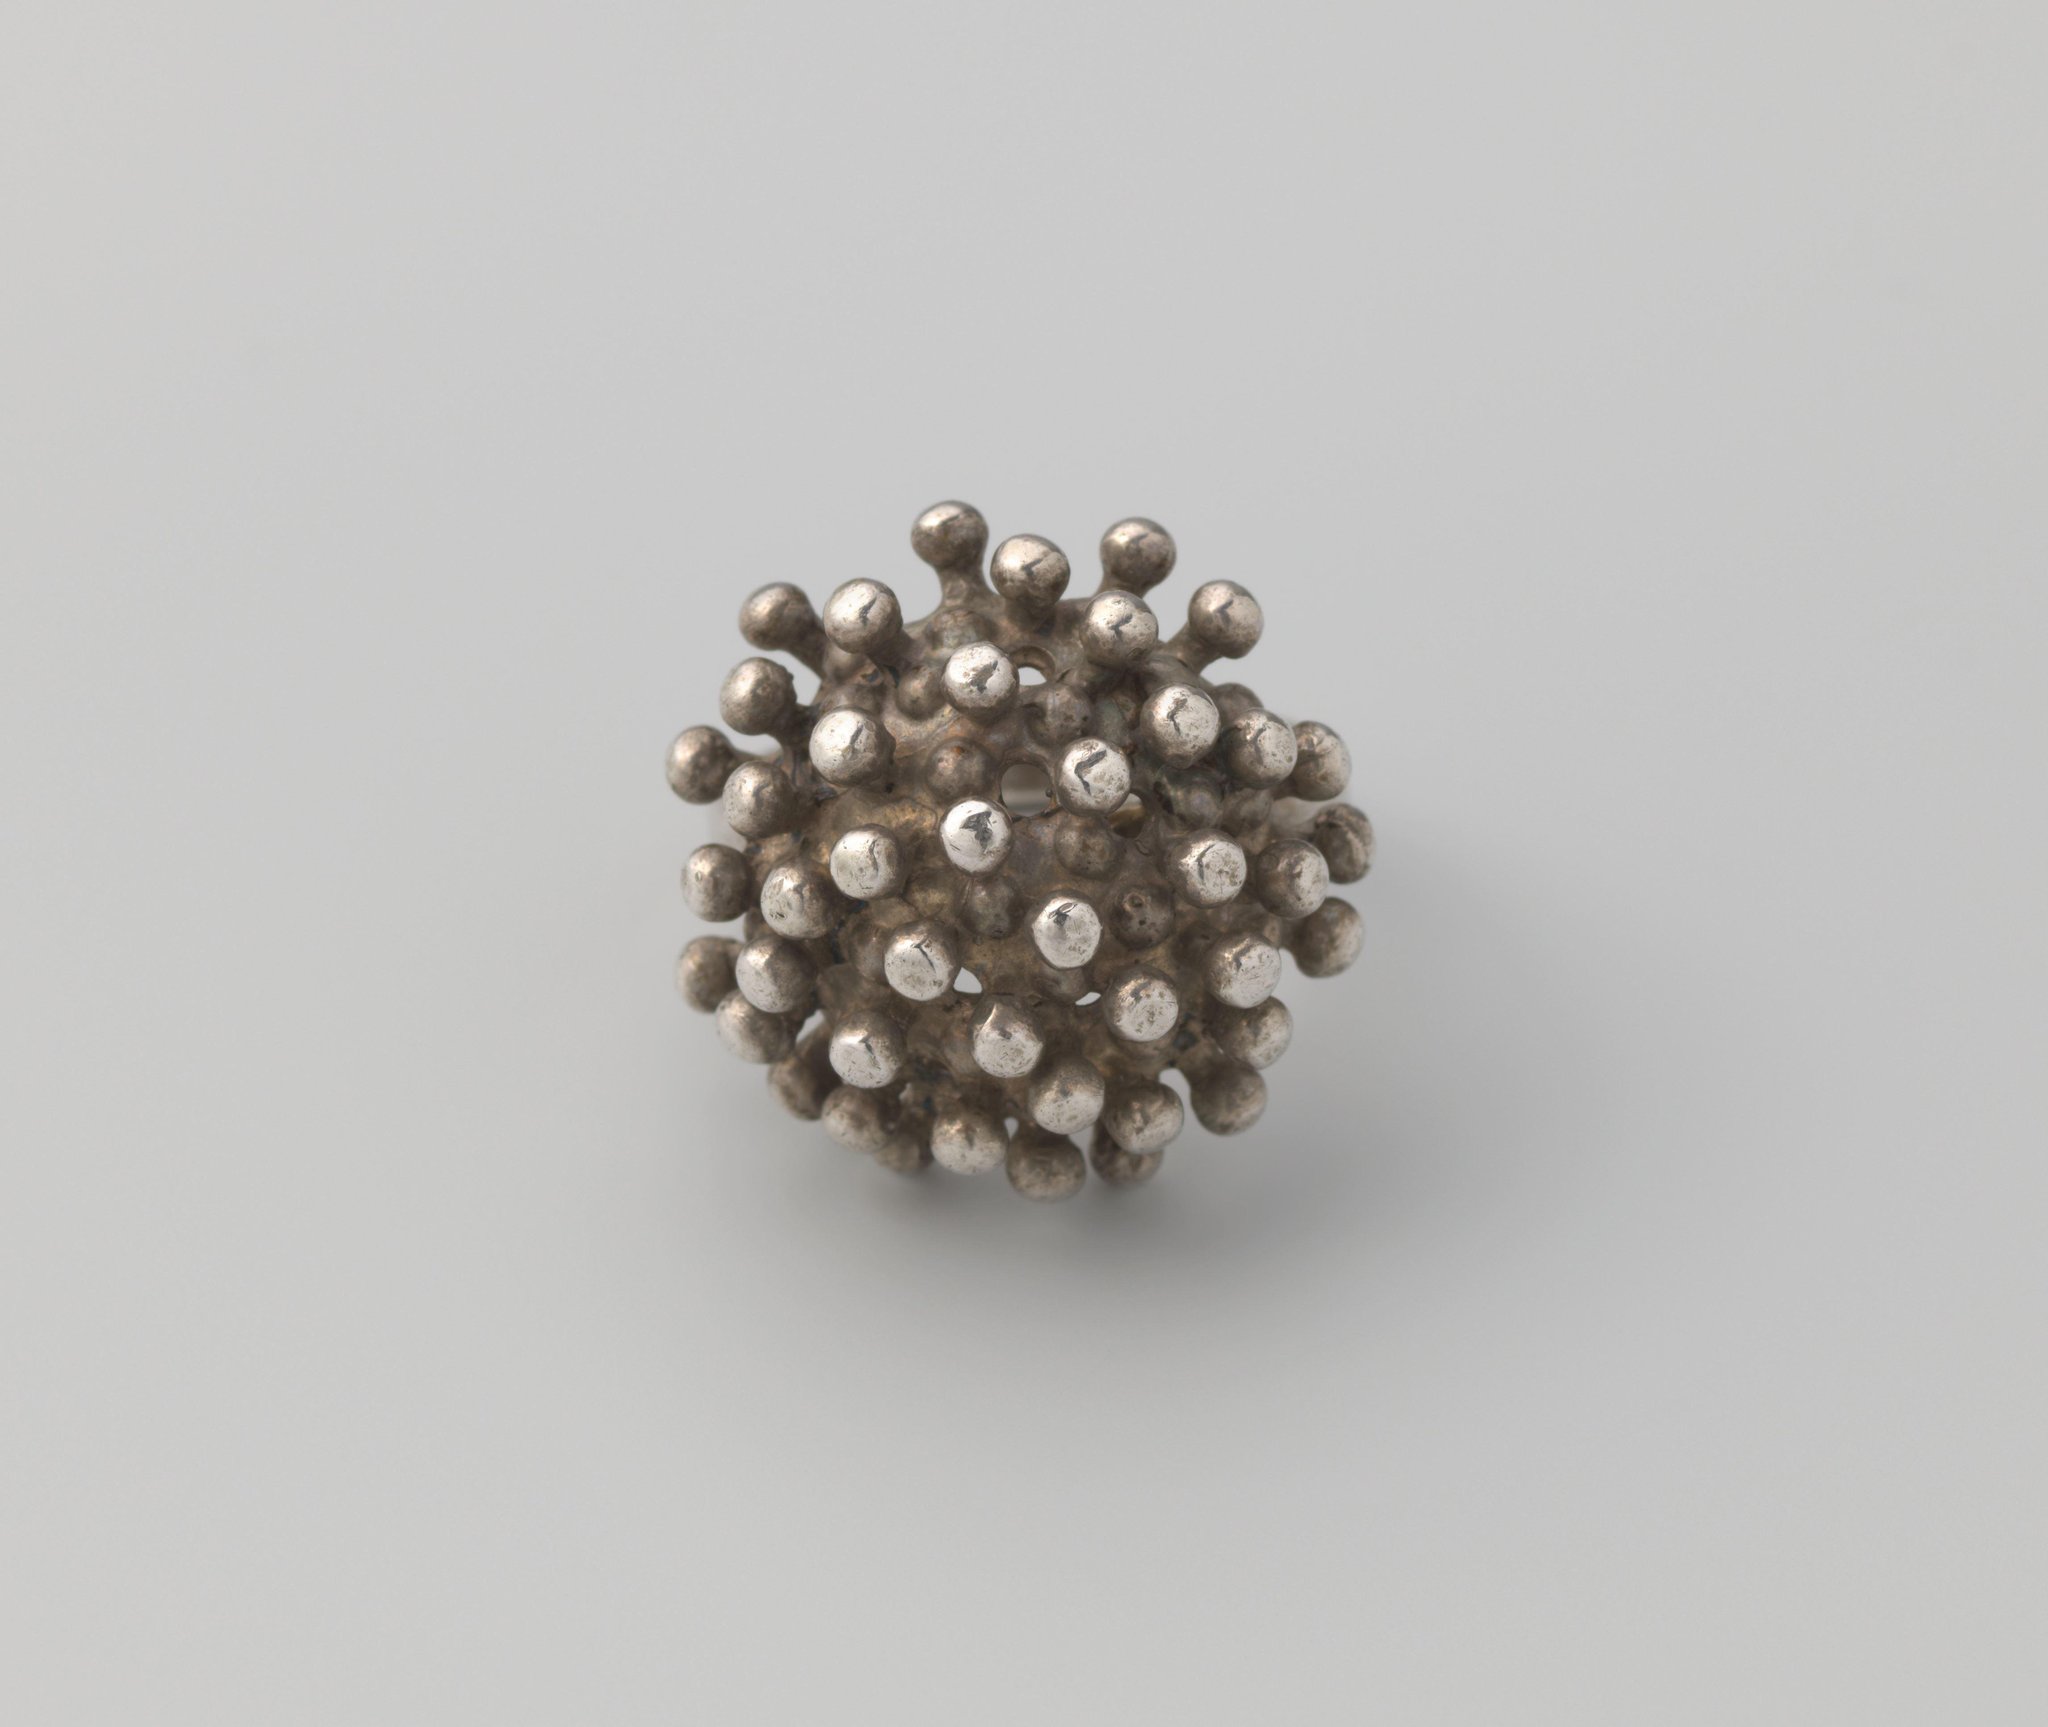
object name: ring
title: Tienerring met bolle knop met uitsteeksels, 'egelring'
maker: Anonymous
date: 1960-1970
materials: silver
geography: netherlands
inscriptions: maker's mark, alloy mark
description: Tienerring van zilver met bolle knop met uitsteeksels, een zogeheten egelring.